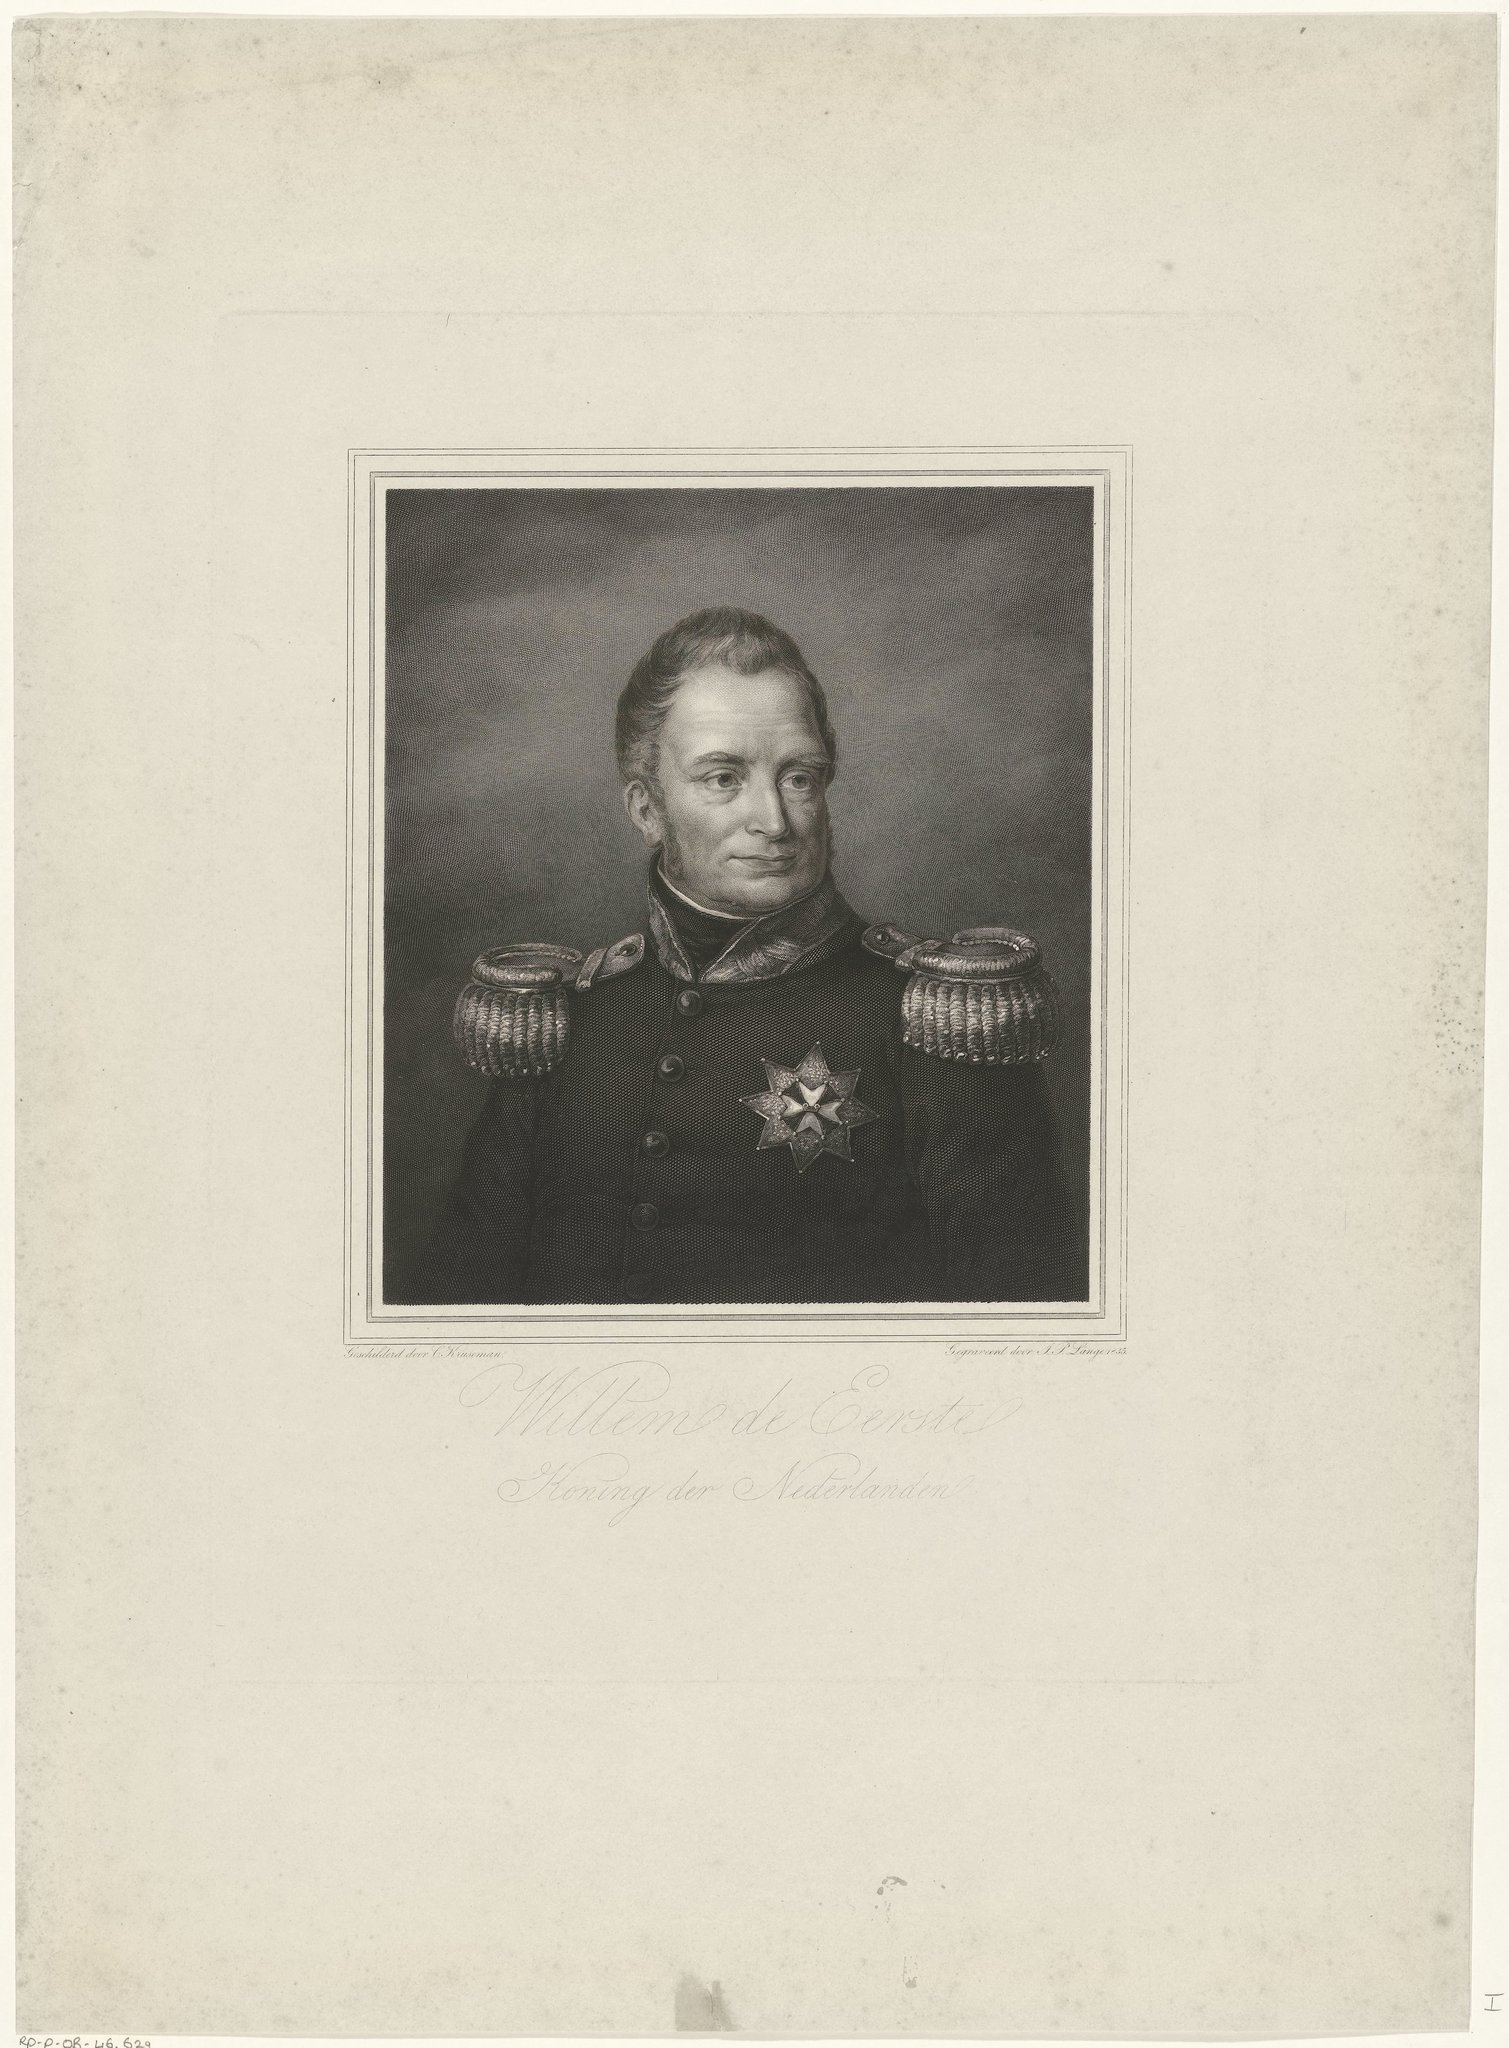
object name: print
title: Portret van Willem I Frederik, koning der Nederlanden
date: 1835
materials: paper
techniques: engraving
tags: the hague, berlin, william i of the netherlands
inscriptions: collector's mark: Lugt 2228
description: Portretbuste van Willem I Frederik, koning der Nederlanden, blootshoofds en gehuld in een uniform met ordester.